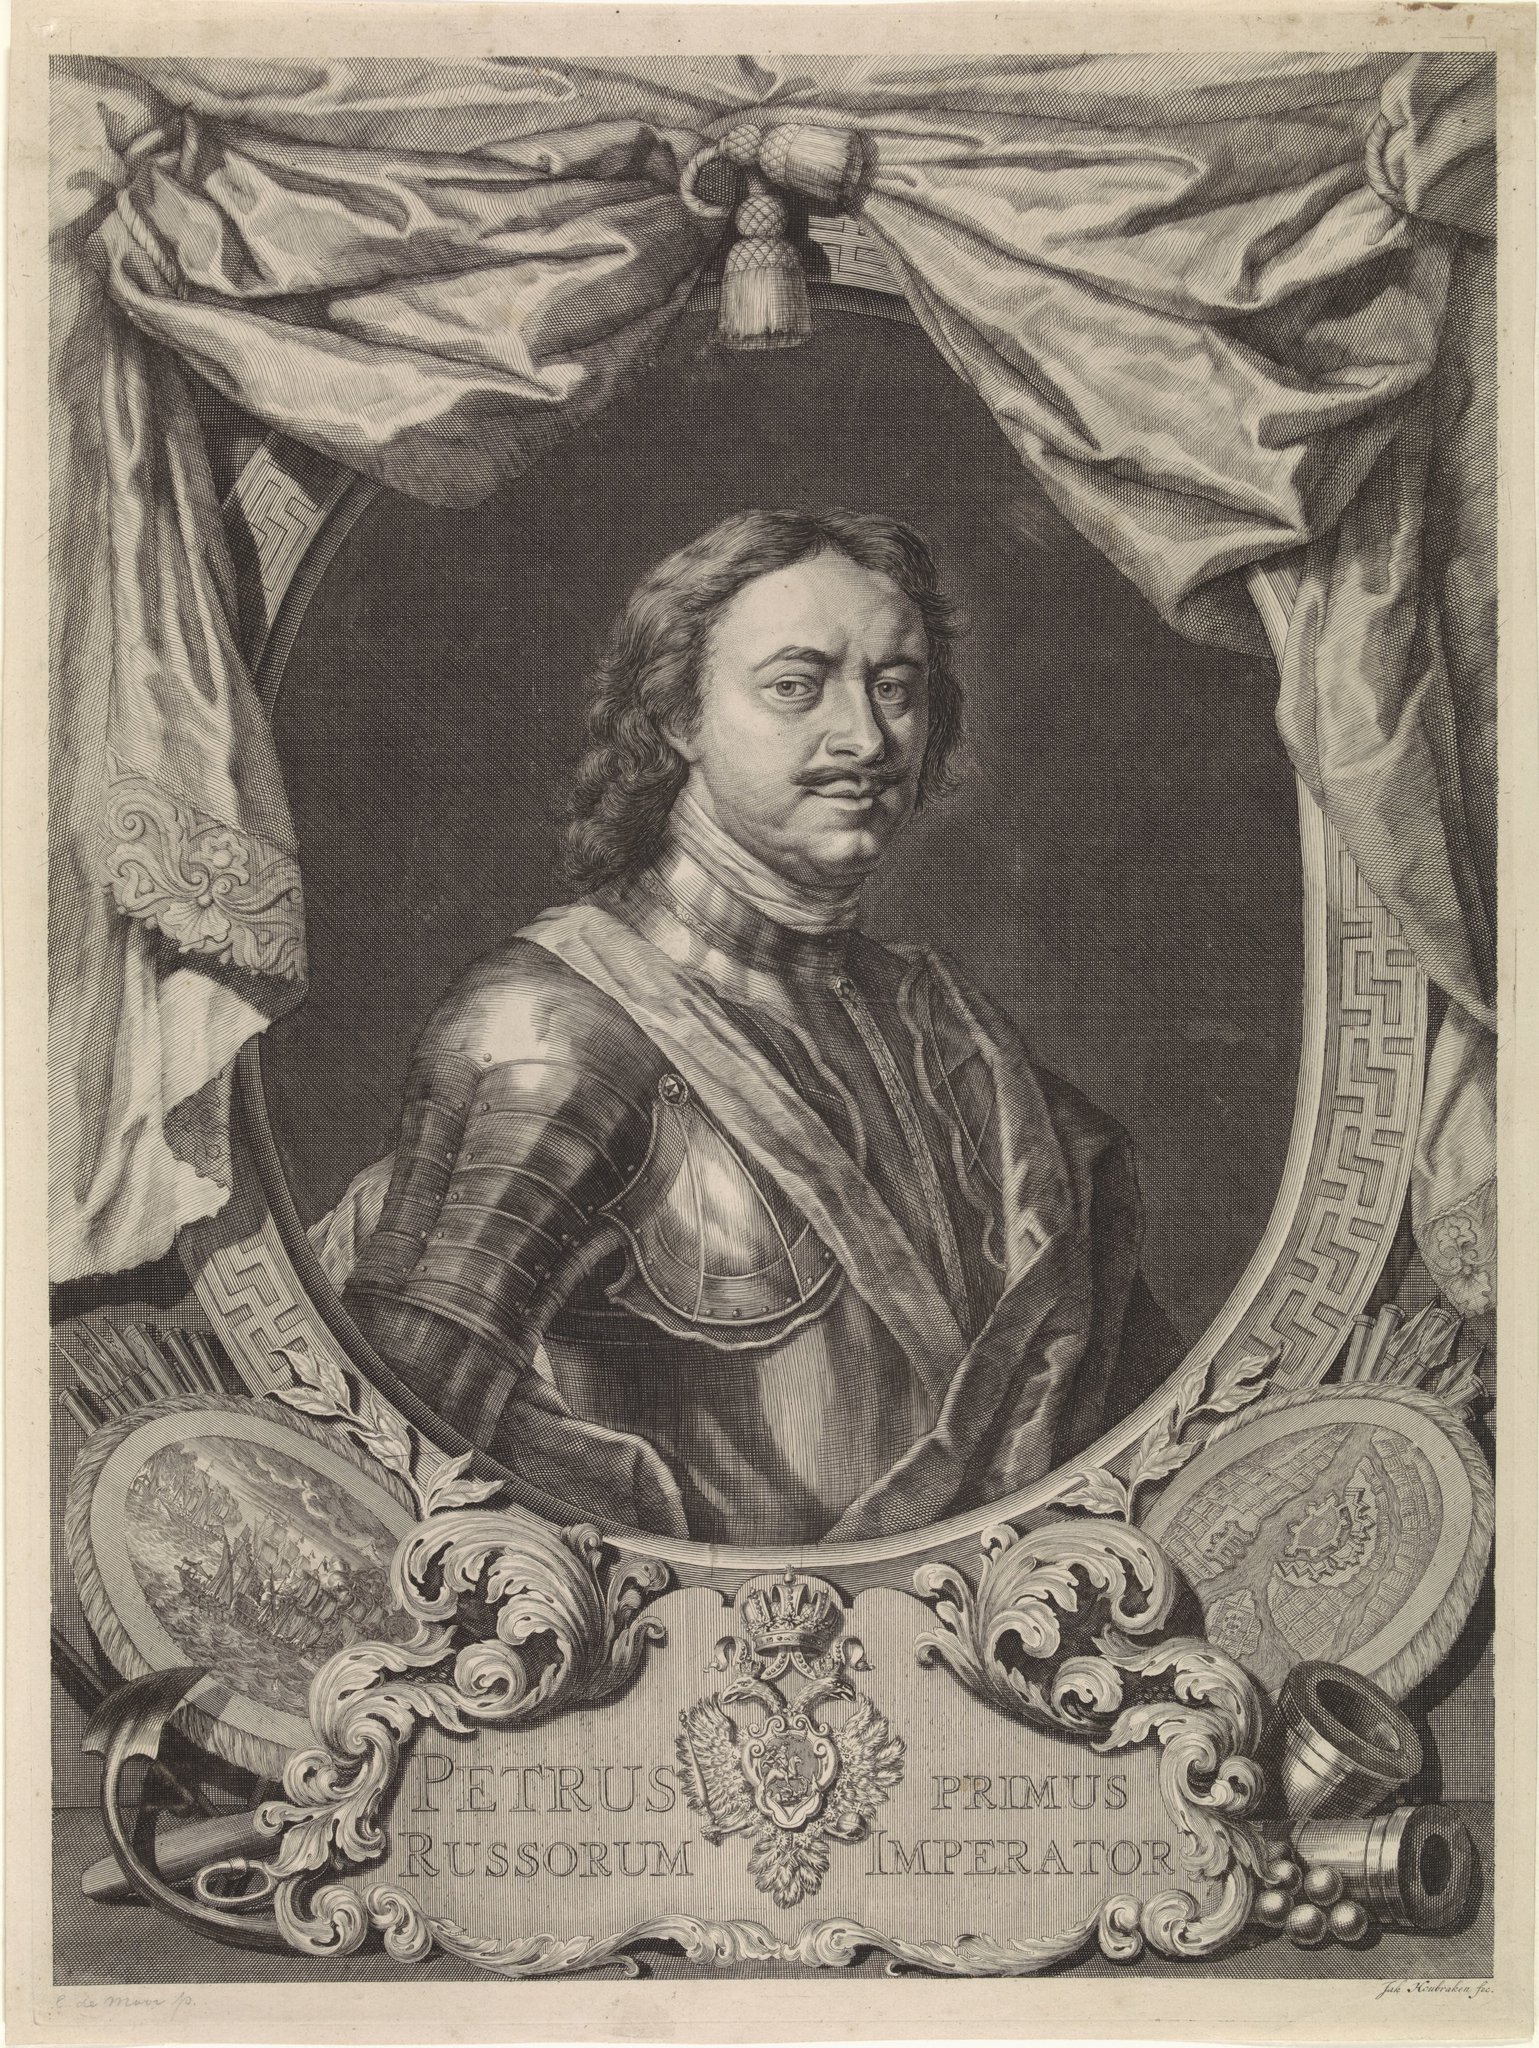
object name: print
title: Portret van Peter I de Grote, tsaar van Rusland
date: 1725-1780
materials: paper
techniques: engraving, etching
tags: peter i de grote (tsaar van rusland)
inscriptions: signature: ‘C. de Moor ... pinxit / D. Onder de Linden Excudit / J. Houbraken Sculps. 1752’, inscription: ‘PETRUS DE 1ste // bygenaamd den Grooten, // KEIZER VAN RUSLAND.’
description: Pendant van het portret van Portret van Catharina I, keizerin van Rusland (RP-P-1906-2397).